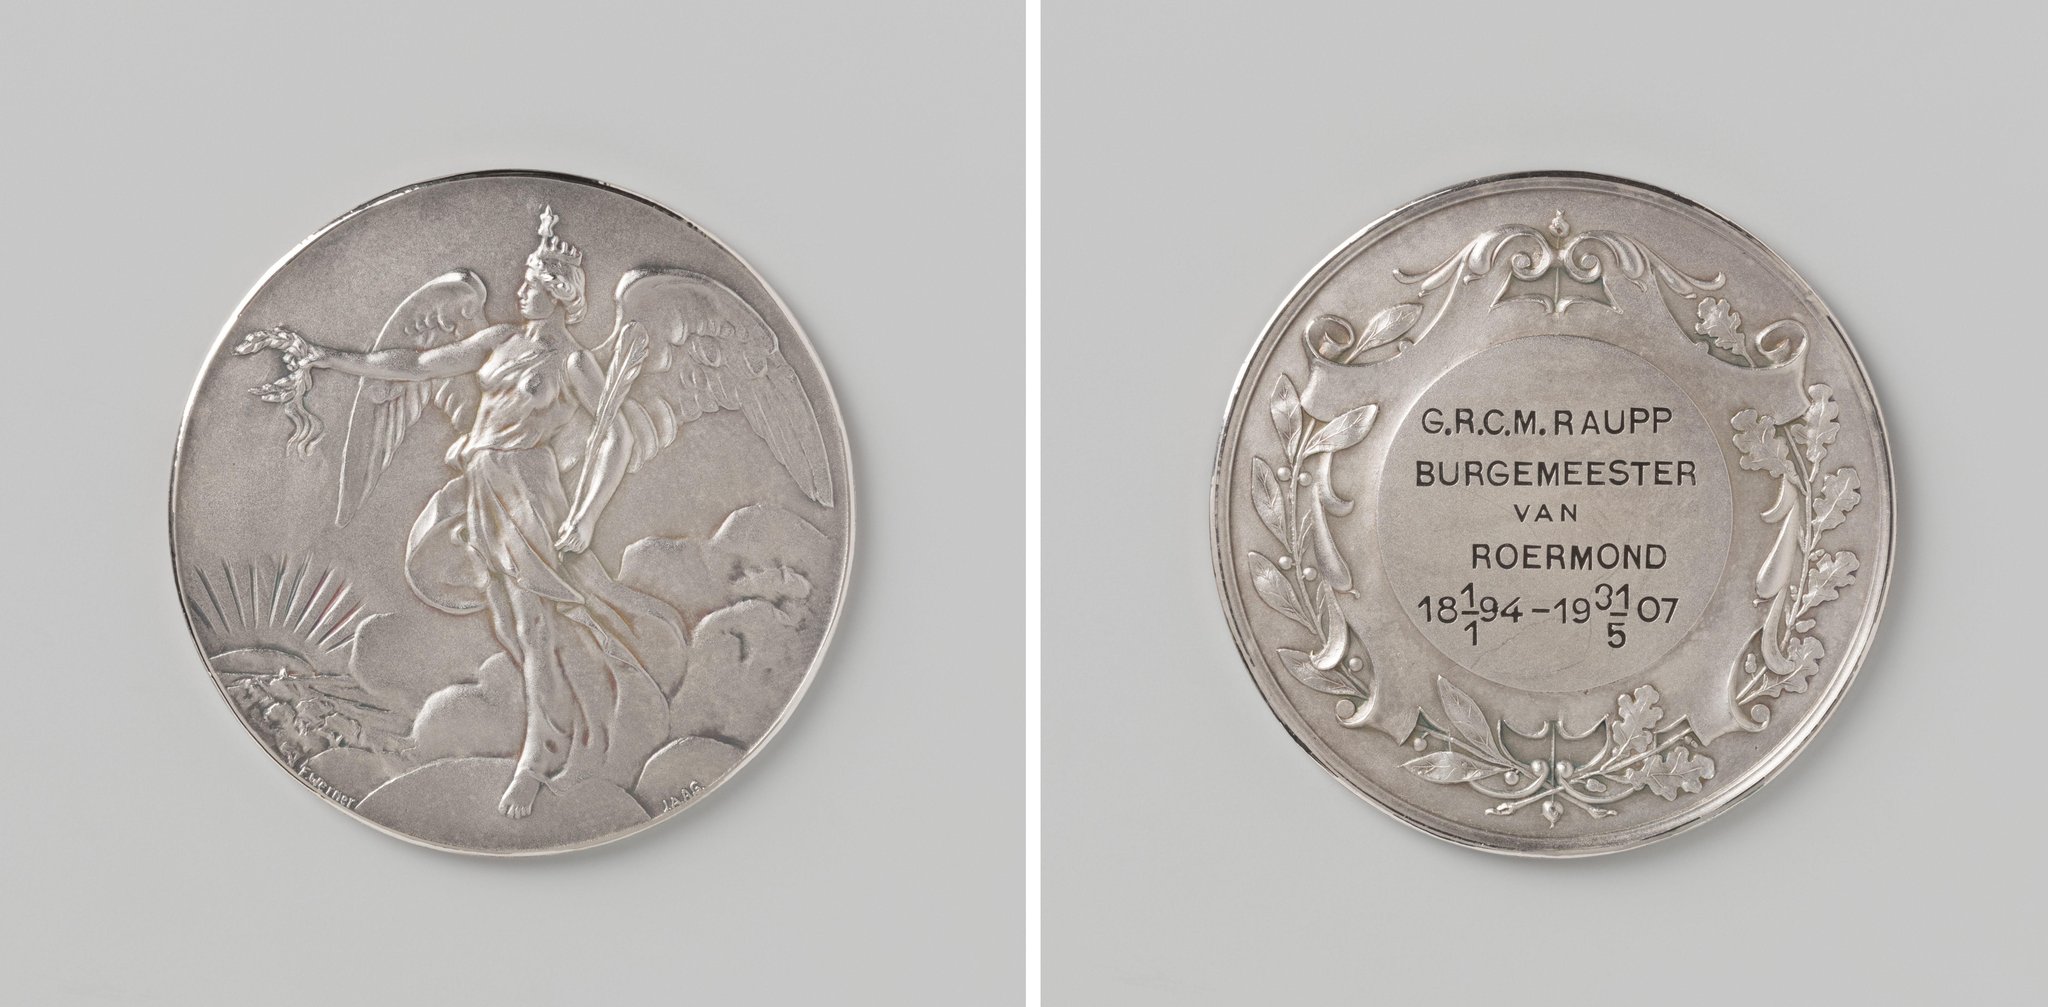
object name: honorary medal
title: G.R.C.M. Raupp, ter ere van zijn aftreden als burgemeester van Roermond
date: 1907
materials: silver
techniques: striking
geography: amsterdam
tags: mayor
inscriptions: inscription: ‘G.R.C.M. RAUPP BURGEMEESTER VAN ROERMOND 18 1/1 94 - 19 31/5 07’, signature: ‘F. WEIDER / J. AAS’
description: Zilveren penning. Voorzijde: gevleugelde vrouw met palmtak in linker- en lauwerkrans in uitgestrekte rechterhand en kroon met ster op hoofd zweeft boven wolken; op achtergrond links: opkomende zon. Keerzijde: opschrift op schild binnen tot krans samengebonden lauwer- en eiketak. Bijbehorend rond kartonnen doosje.